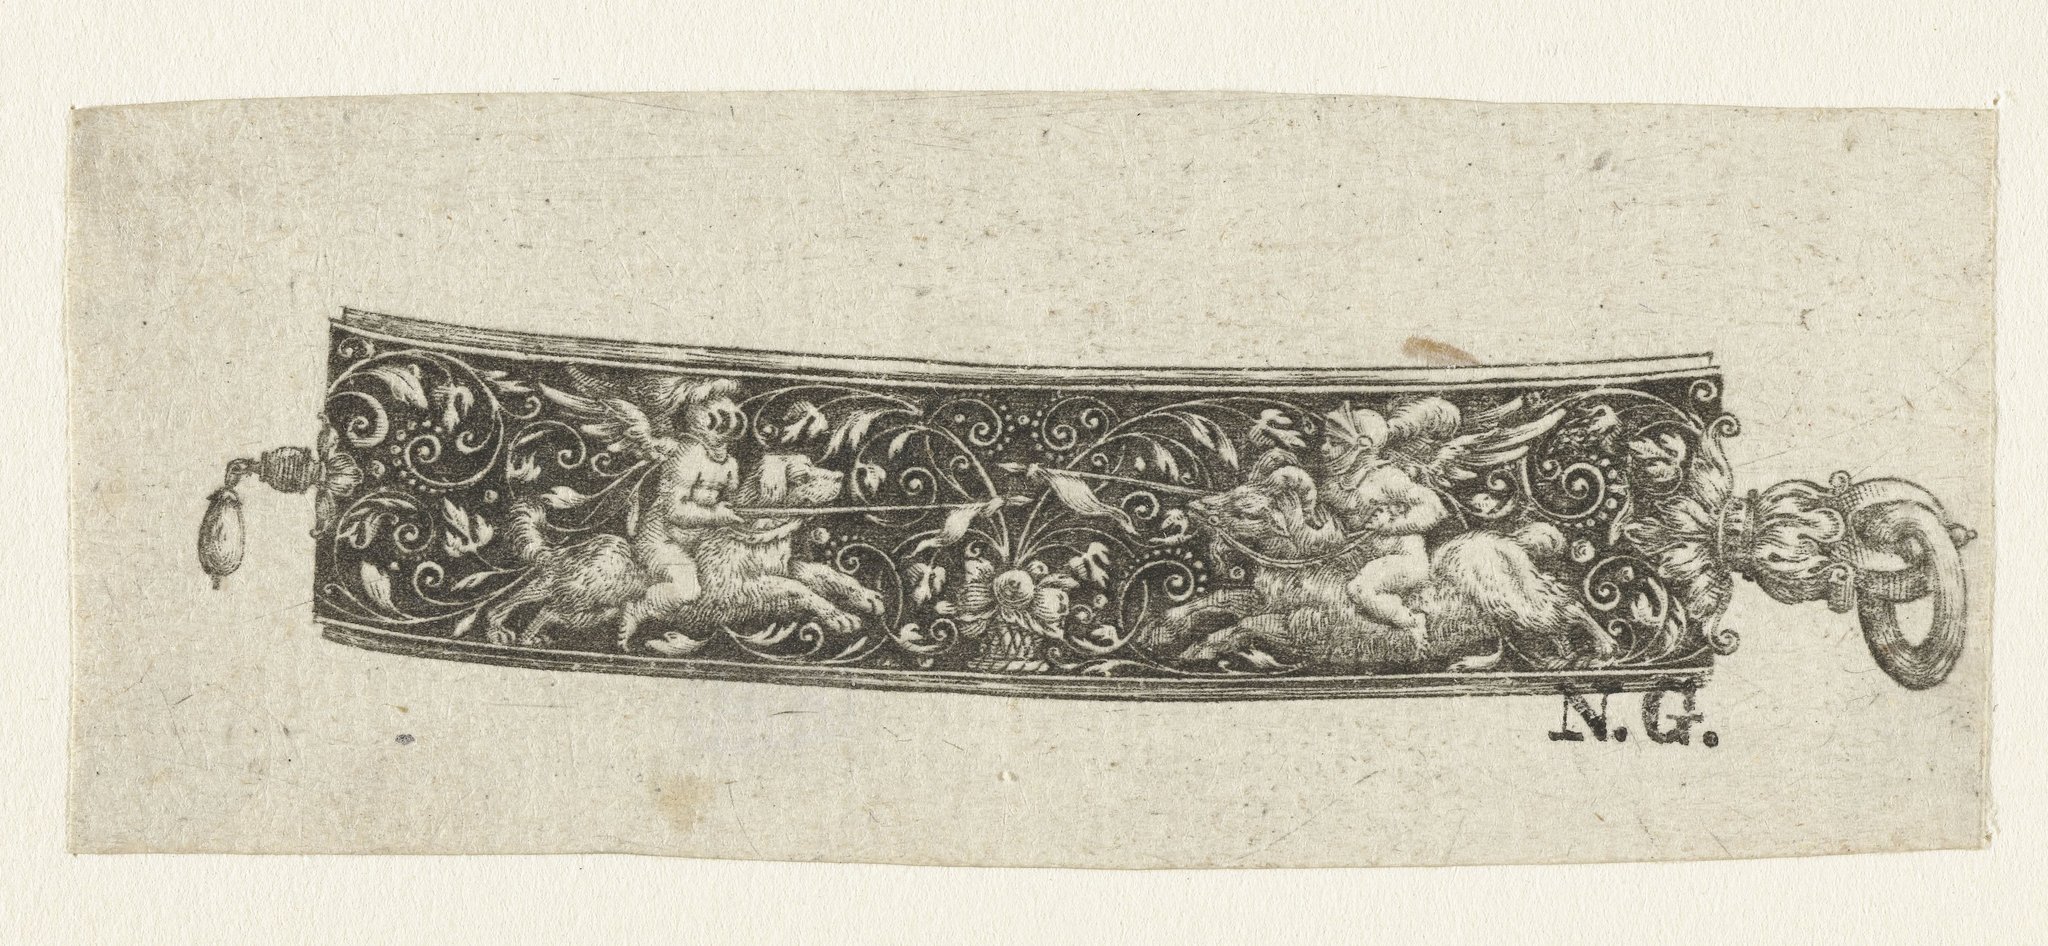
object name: print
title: Armband met putti rijdend op een hond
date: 1610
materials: paper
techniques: engraving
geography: amsterdam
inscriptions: collector's mark: Lugt 1968